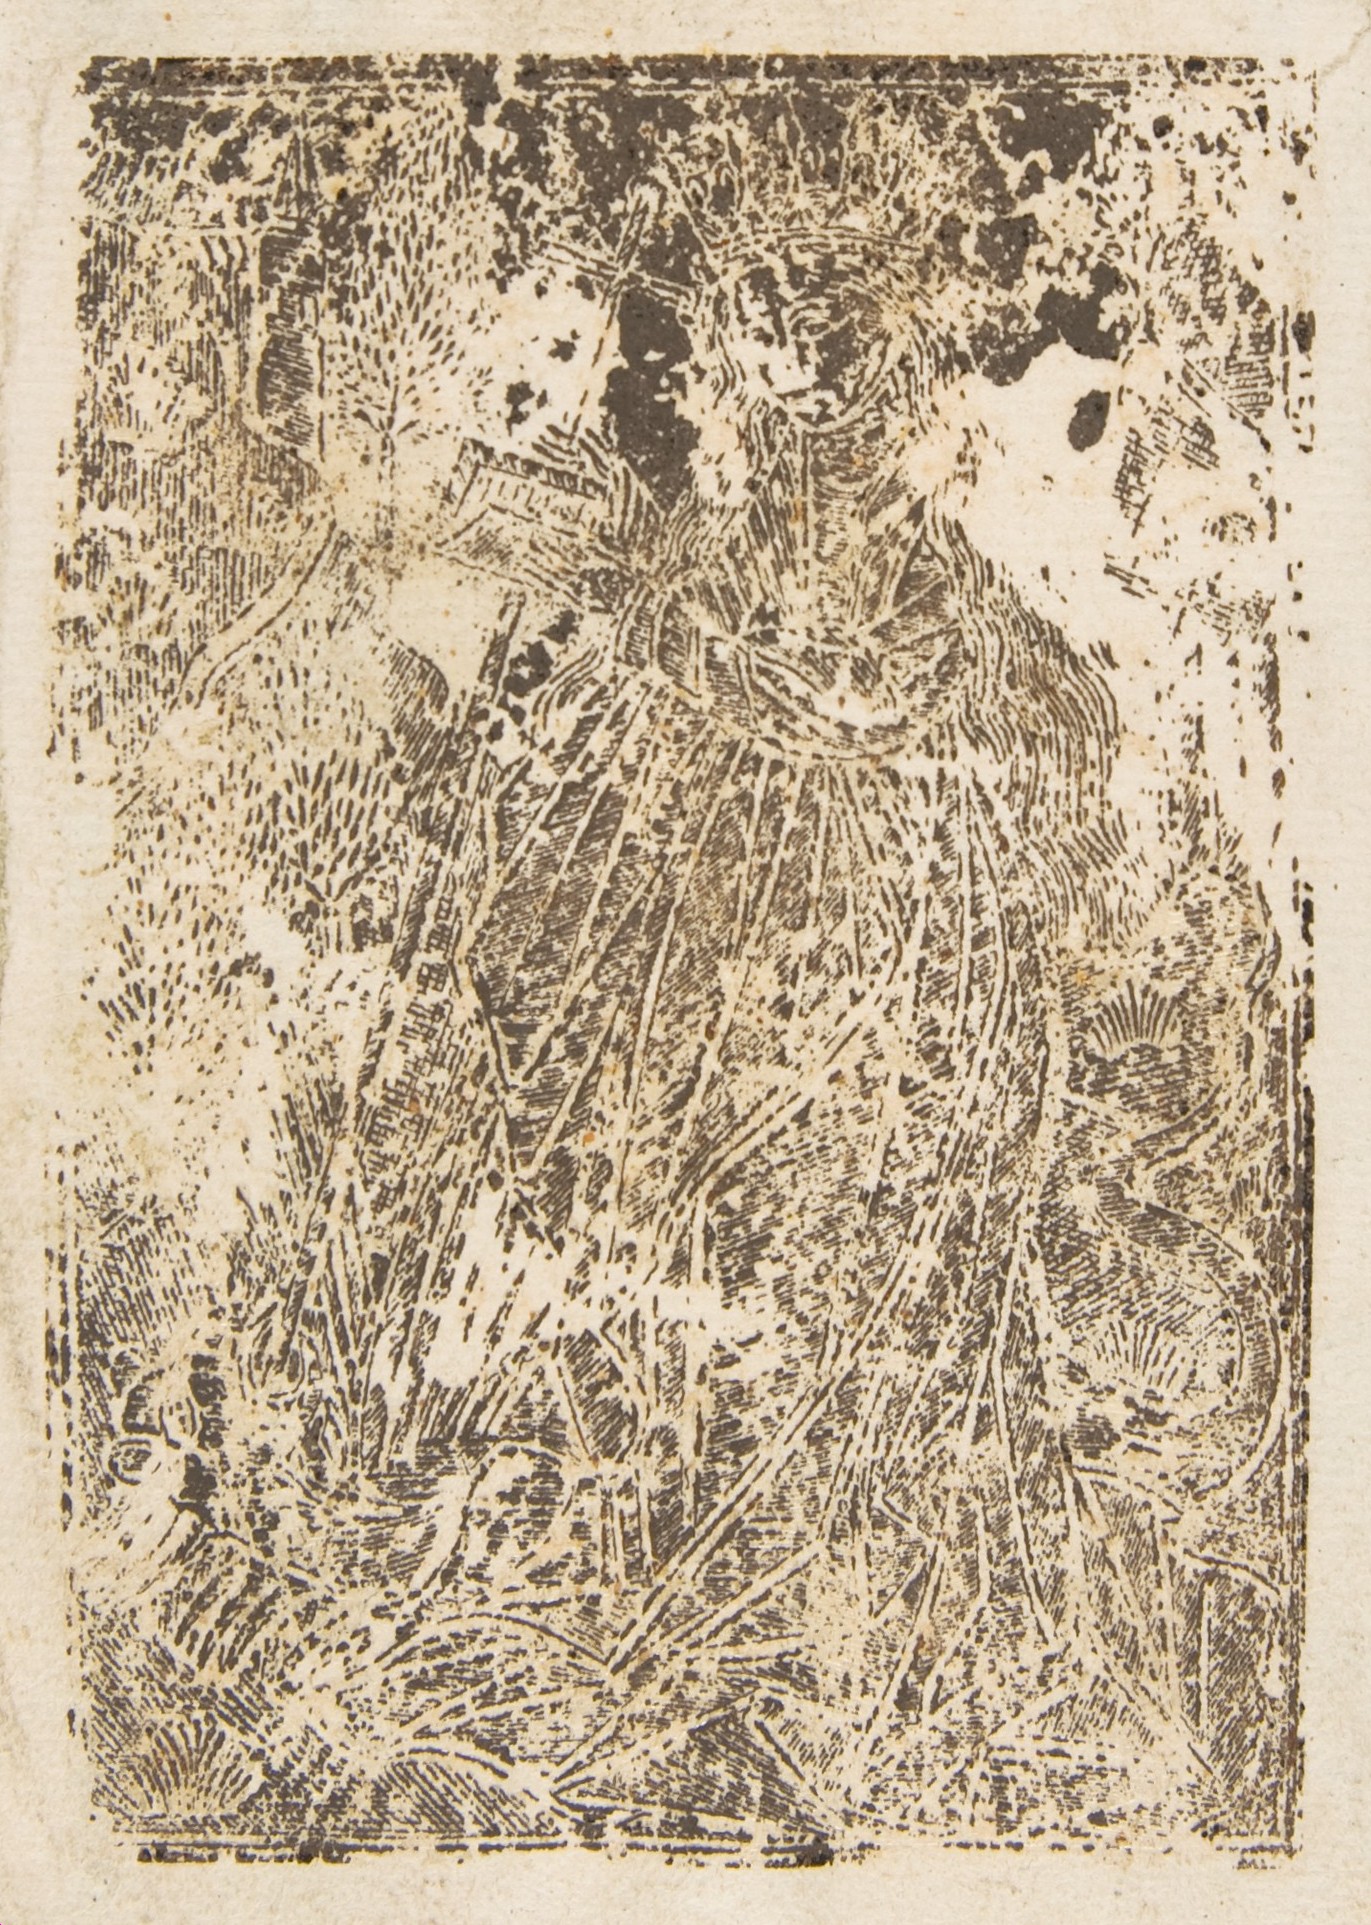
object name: print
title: St. Margaret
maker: anonymous, german, 15th century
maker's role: artist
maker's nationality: german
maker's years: 1400-1500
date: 1401-1500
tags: women,saints